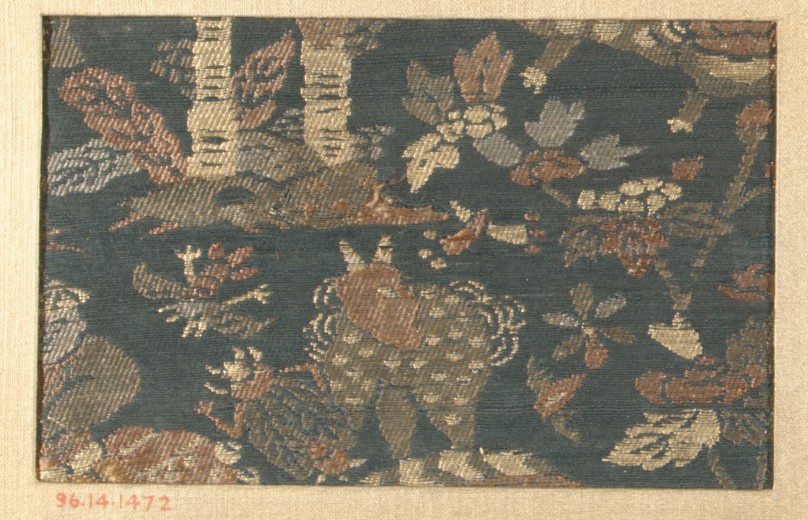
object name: piece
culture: japanese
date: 1701-1900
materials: silk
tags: animals,boys,insects